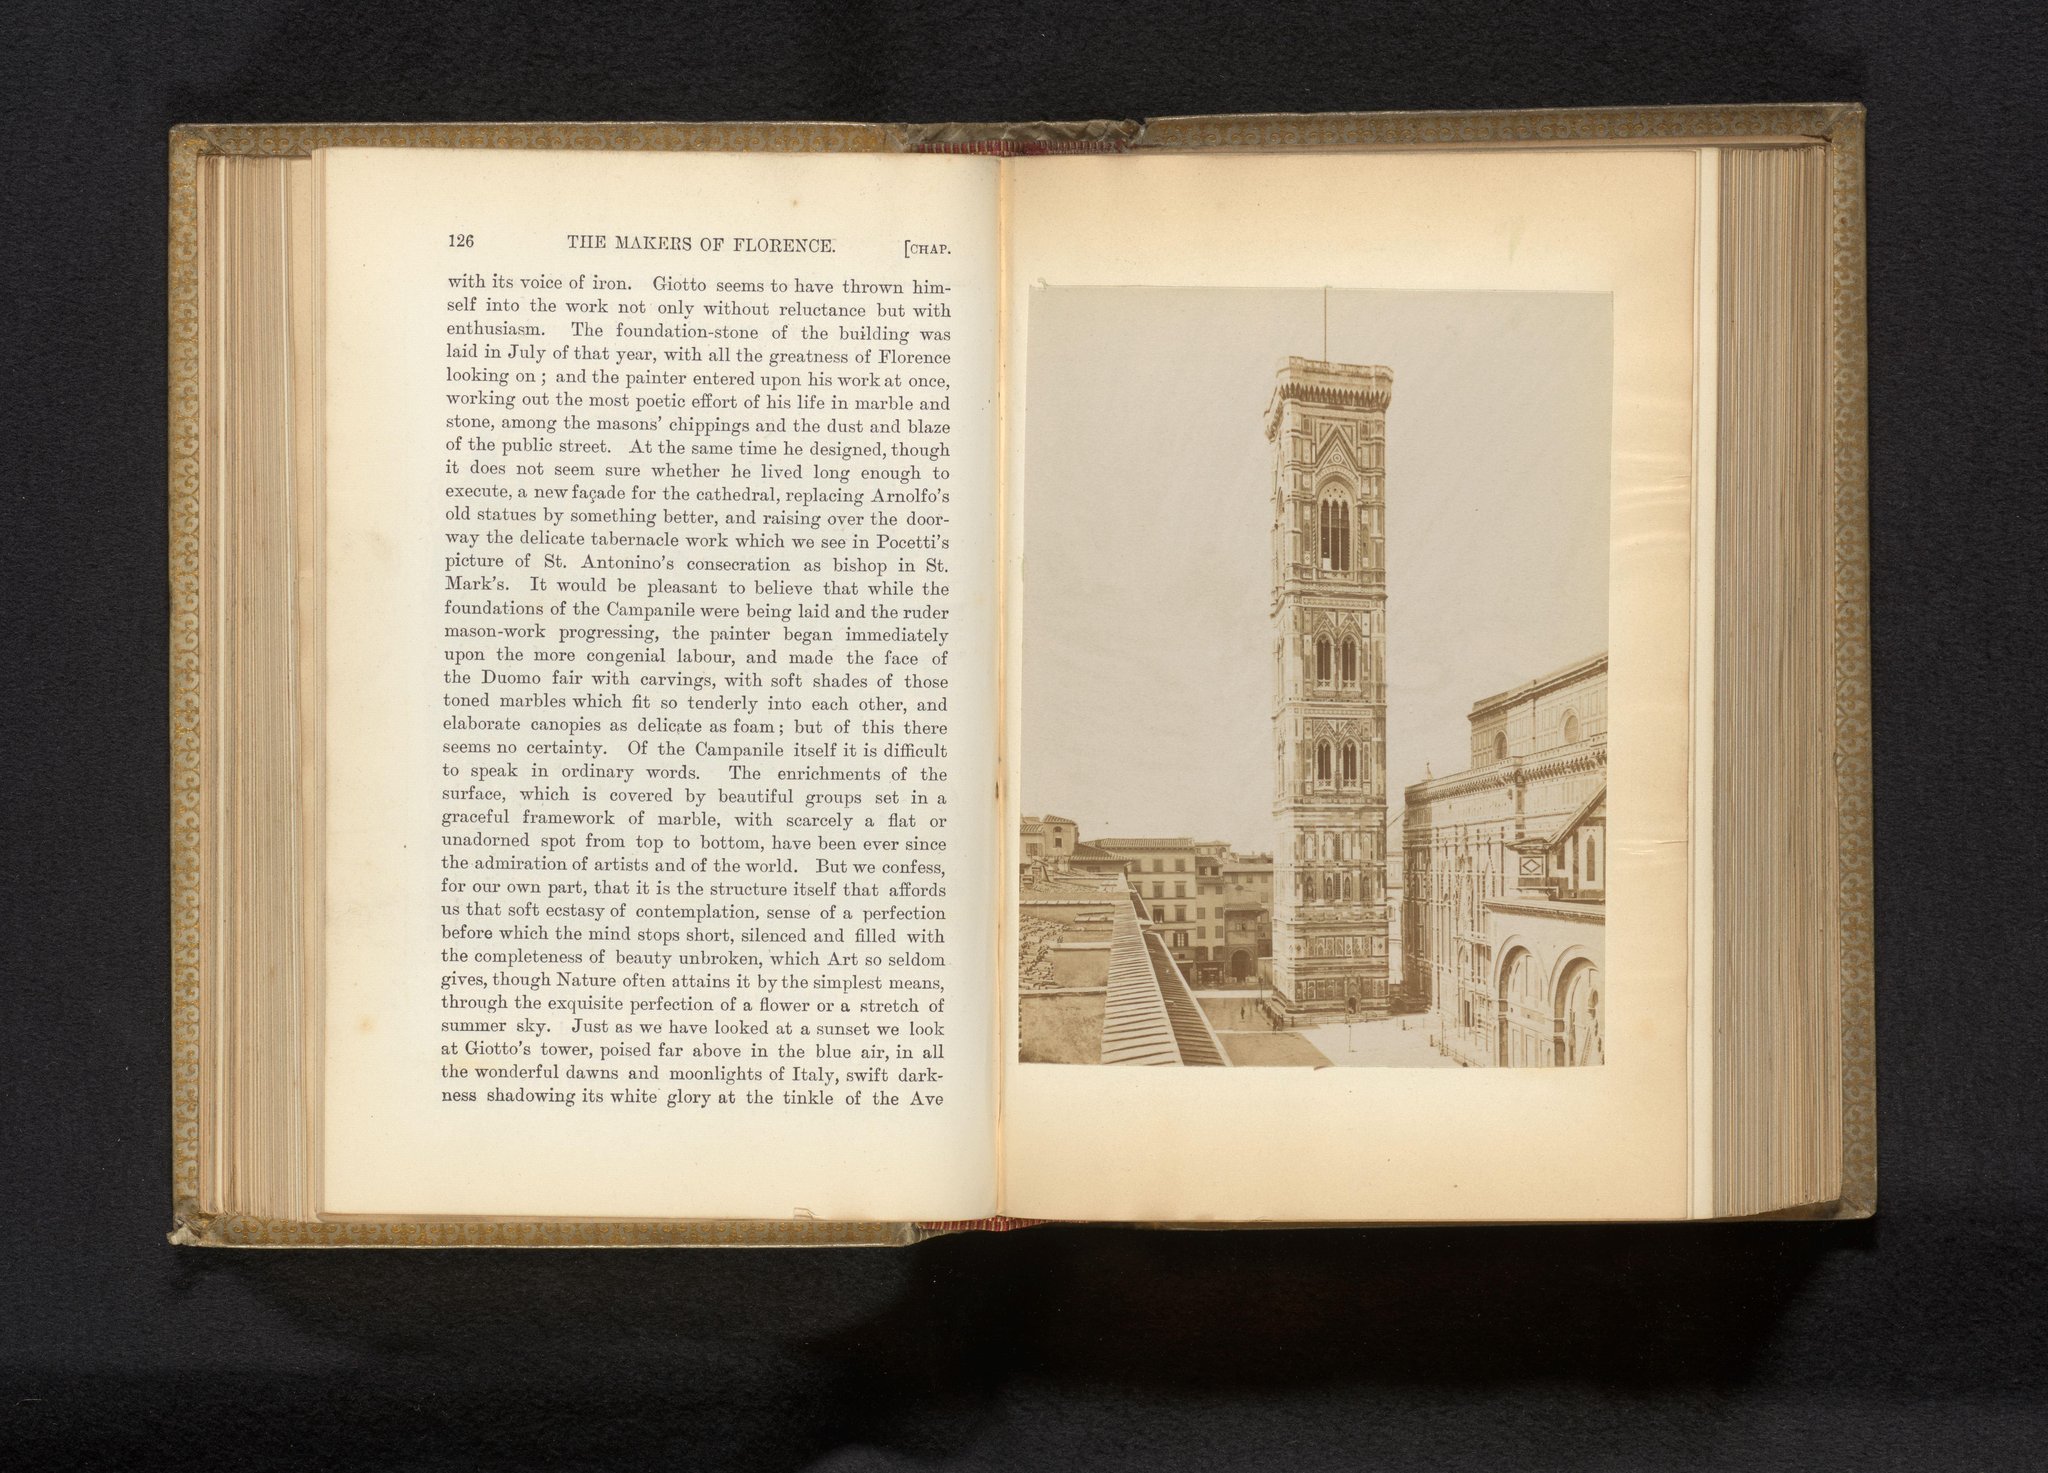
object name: page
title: Campanile van de Dom van Florence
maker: Anonymous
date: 1878-1888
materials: photographic support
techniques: albumen print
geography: florence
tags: parts of church exterior and annexes: campanile